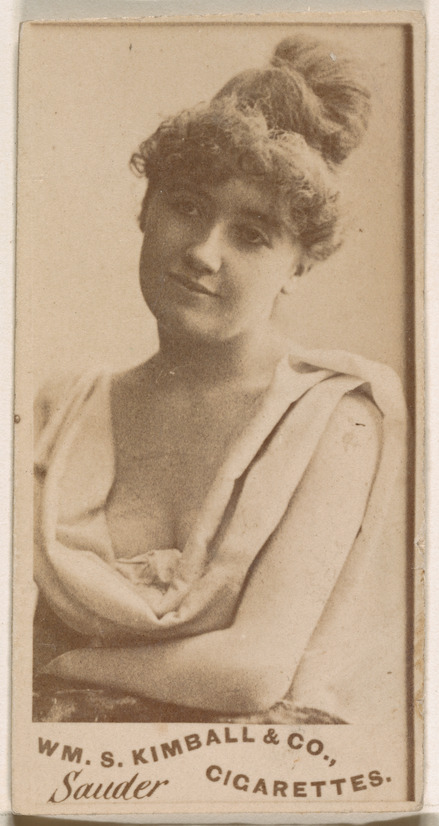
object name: photograph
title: Miss Sauder, from the Actresses series (N203) issued by Wm. S. Kimball & Co.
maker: william s. kimball & company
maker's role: publisher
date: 1889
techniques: color lithograph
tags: portraits,women,actresses